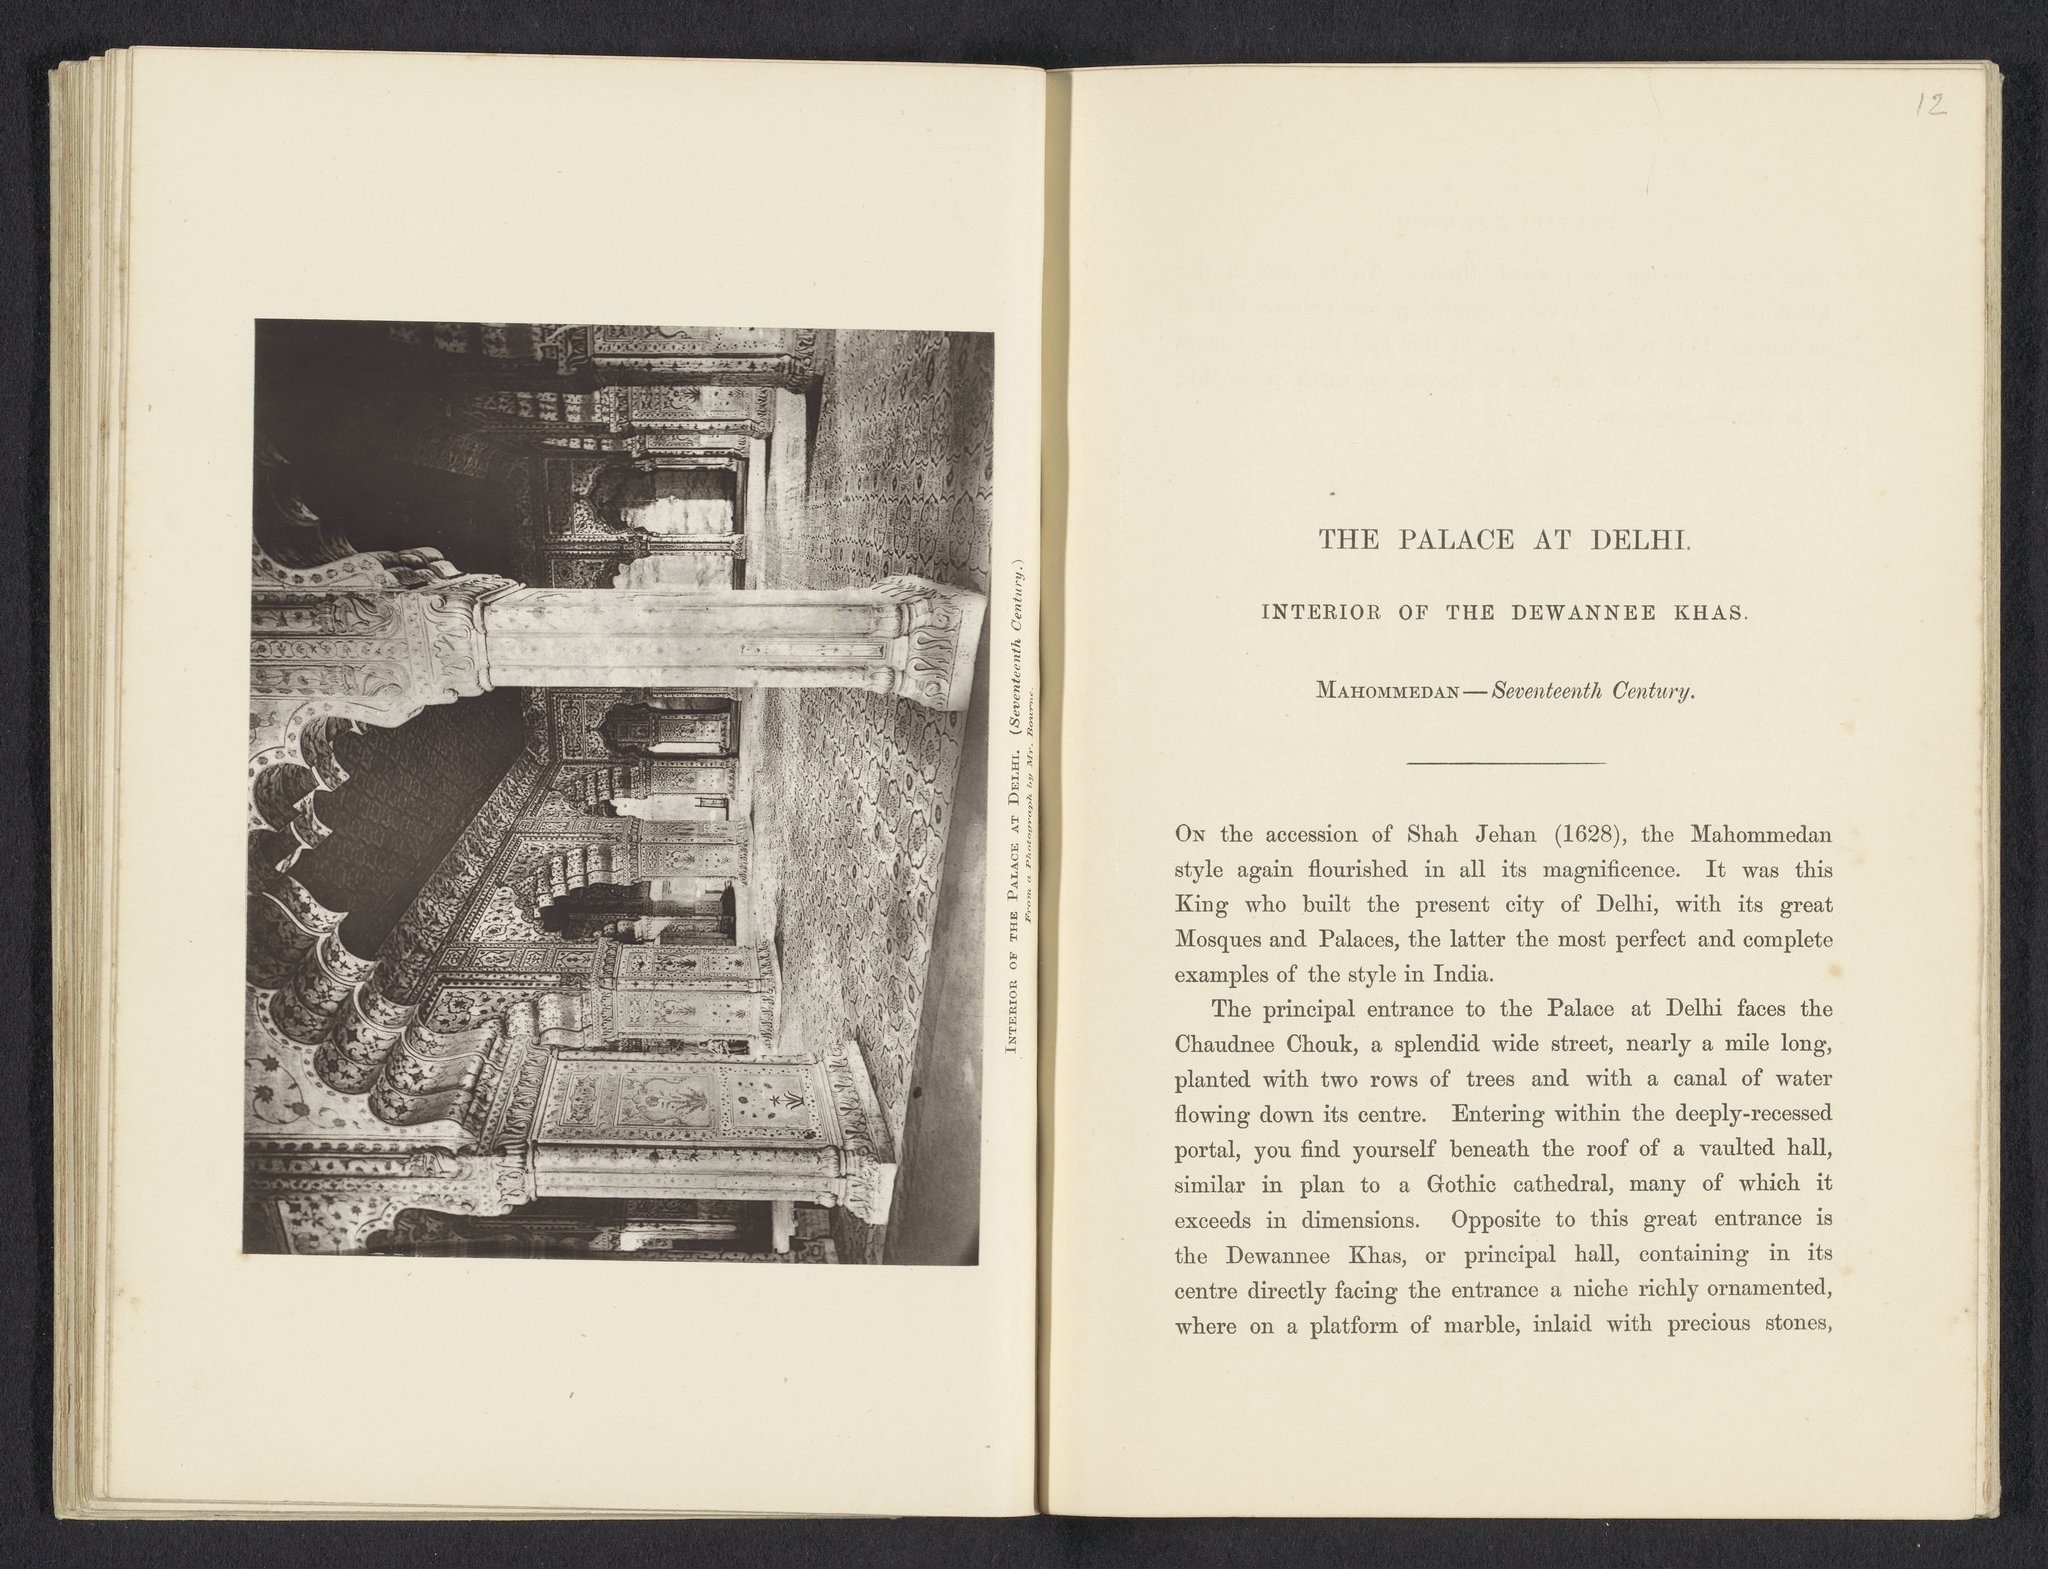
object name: photomechanical print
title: Interior of the Diwan-i-Khas in the Red Fort at Delhi, India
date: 1864-1869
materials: paper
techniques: woodburytype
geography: diwan-i-khas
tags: palace, exterior ~ representation of a building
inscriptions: caption: ‘INTERIOR OF THE PALACE AT DELHI. (Seventeenth Century.)/ From a Photograph by Mr. Bourne.’